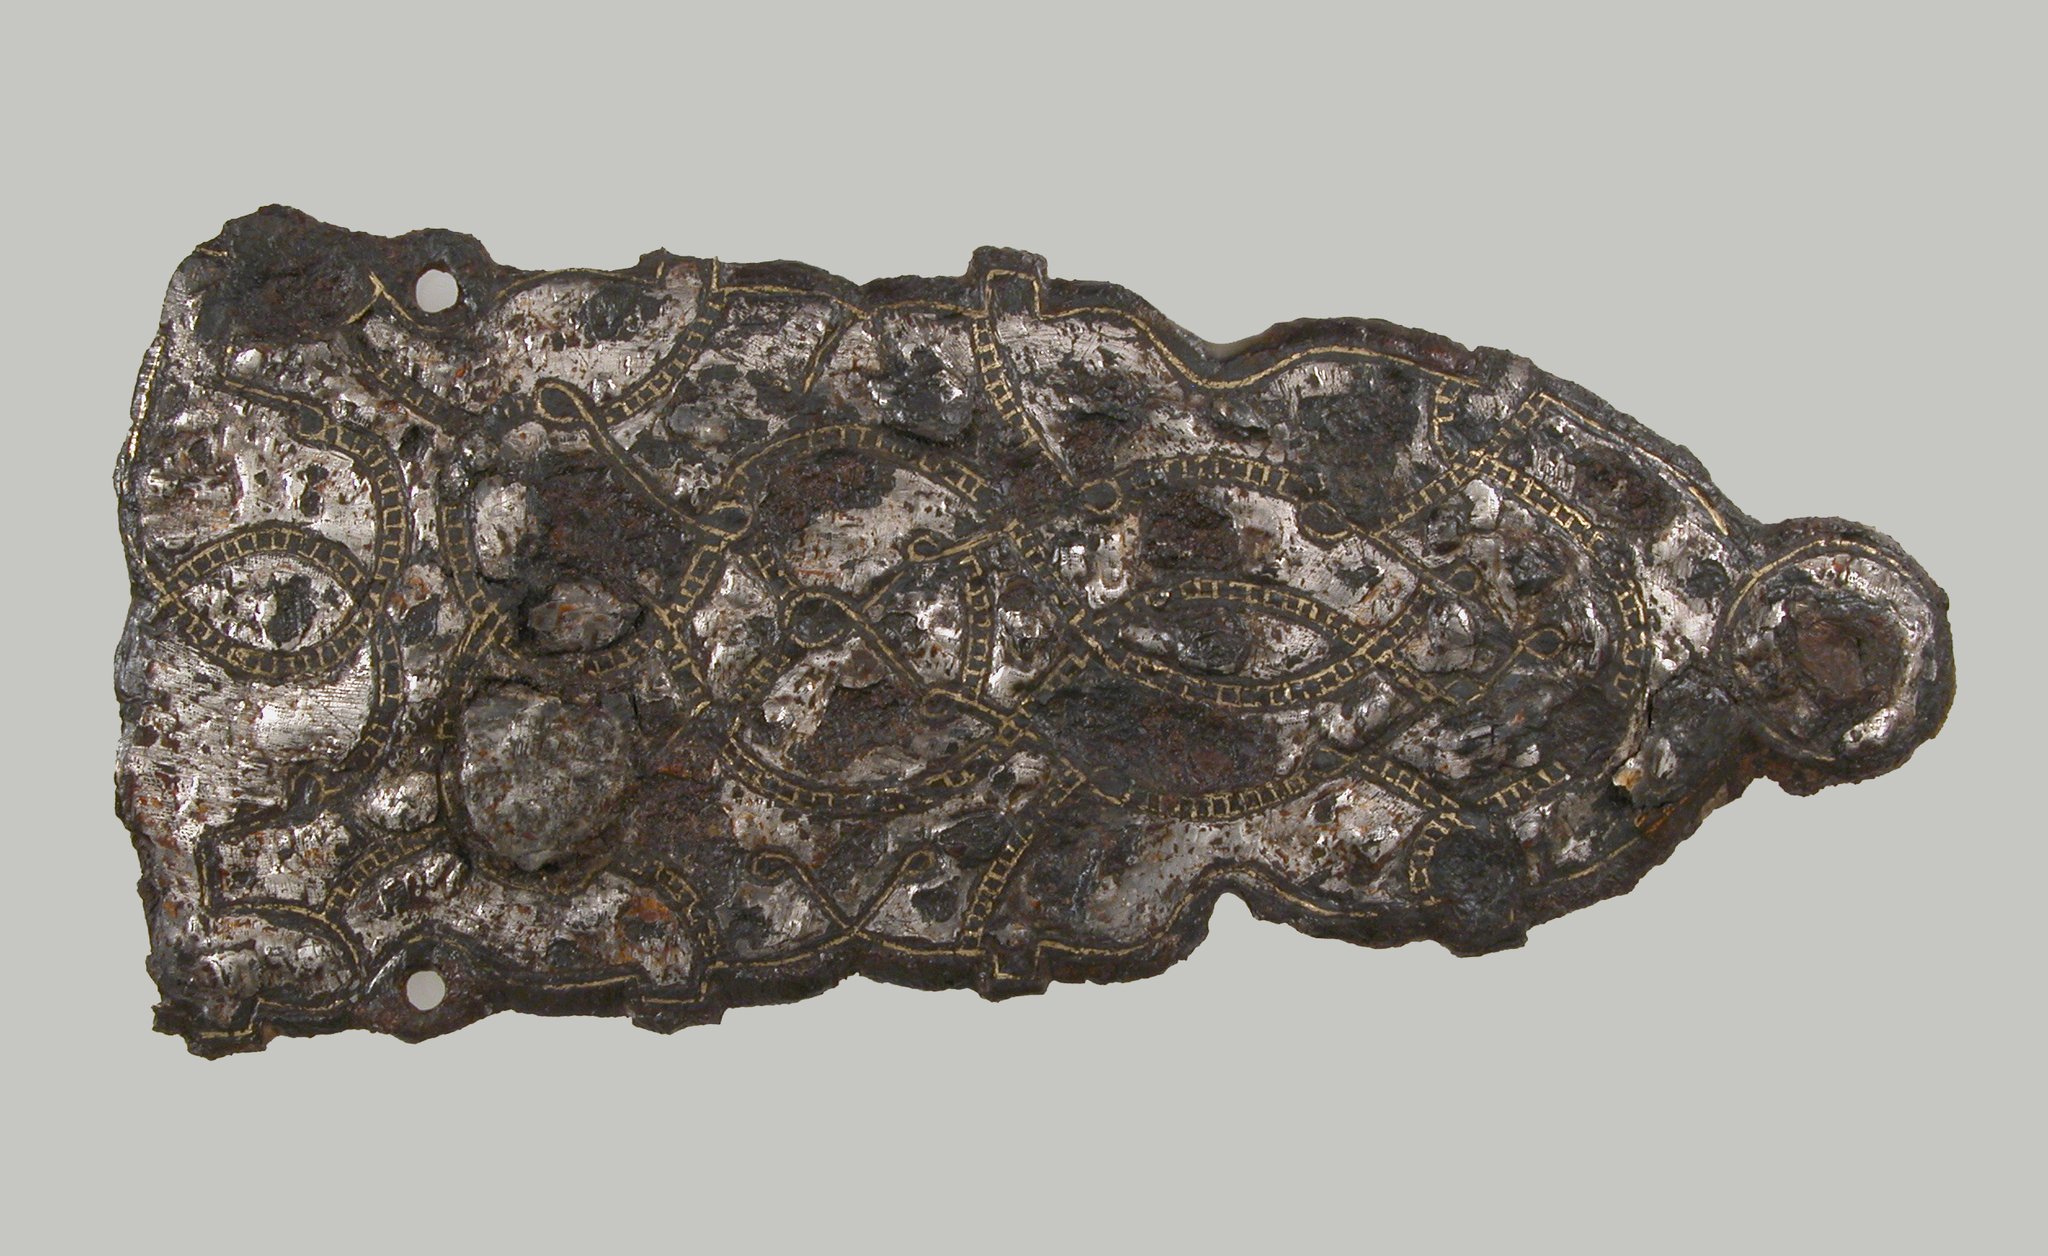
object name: belt plate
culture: burgundian or frankish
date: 601-700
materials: brass, gold, iron, silver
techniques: inlay